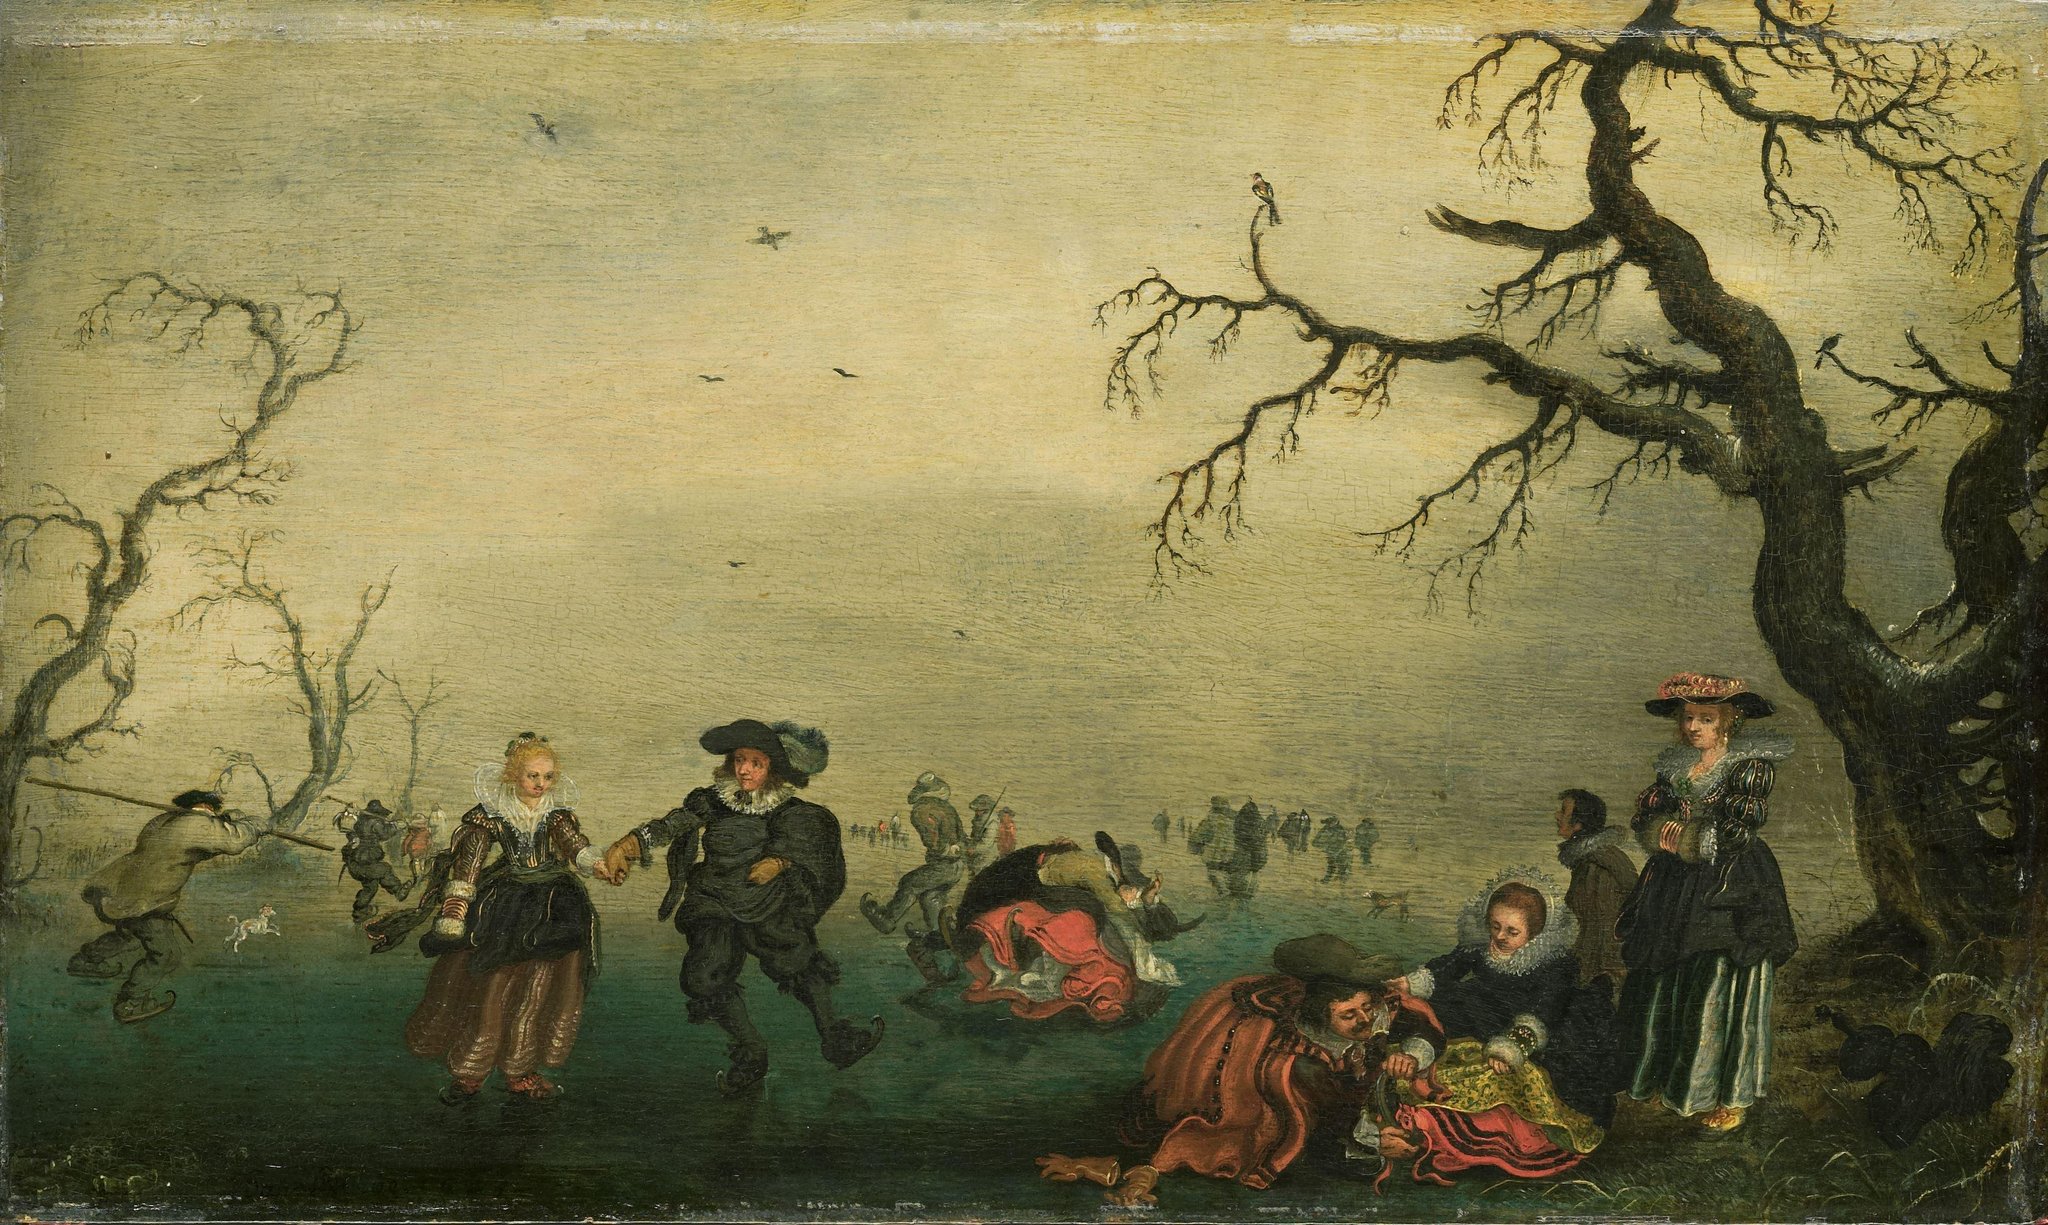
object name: painting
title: Ice Skaters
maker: adriaen pietersz van de venne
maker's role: draughtsman, painter, print maker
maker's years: 1589-1662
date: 1625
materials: oil, panel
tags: winter landscape; landscape symbolizing winter (the four seasons of the year), skates (winter sports) (+ accident (in sports, games, etc.))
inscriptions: signature and date, bottom left (A and V ligated): ‘Avan de Venne 1625’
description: Winterlandschap met schaatsenrijders op het ijs. Op het ijs enige elegante paren, rechts bindt een heer bij een dame de schaatsen onder.